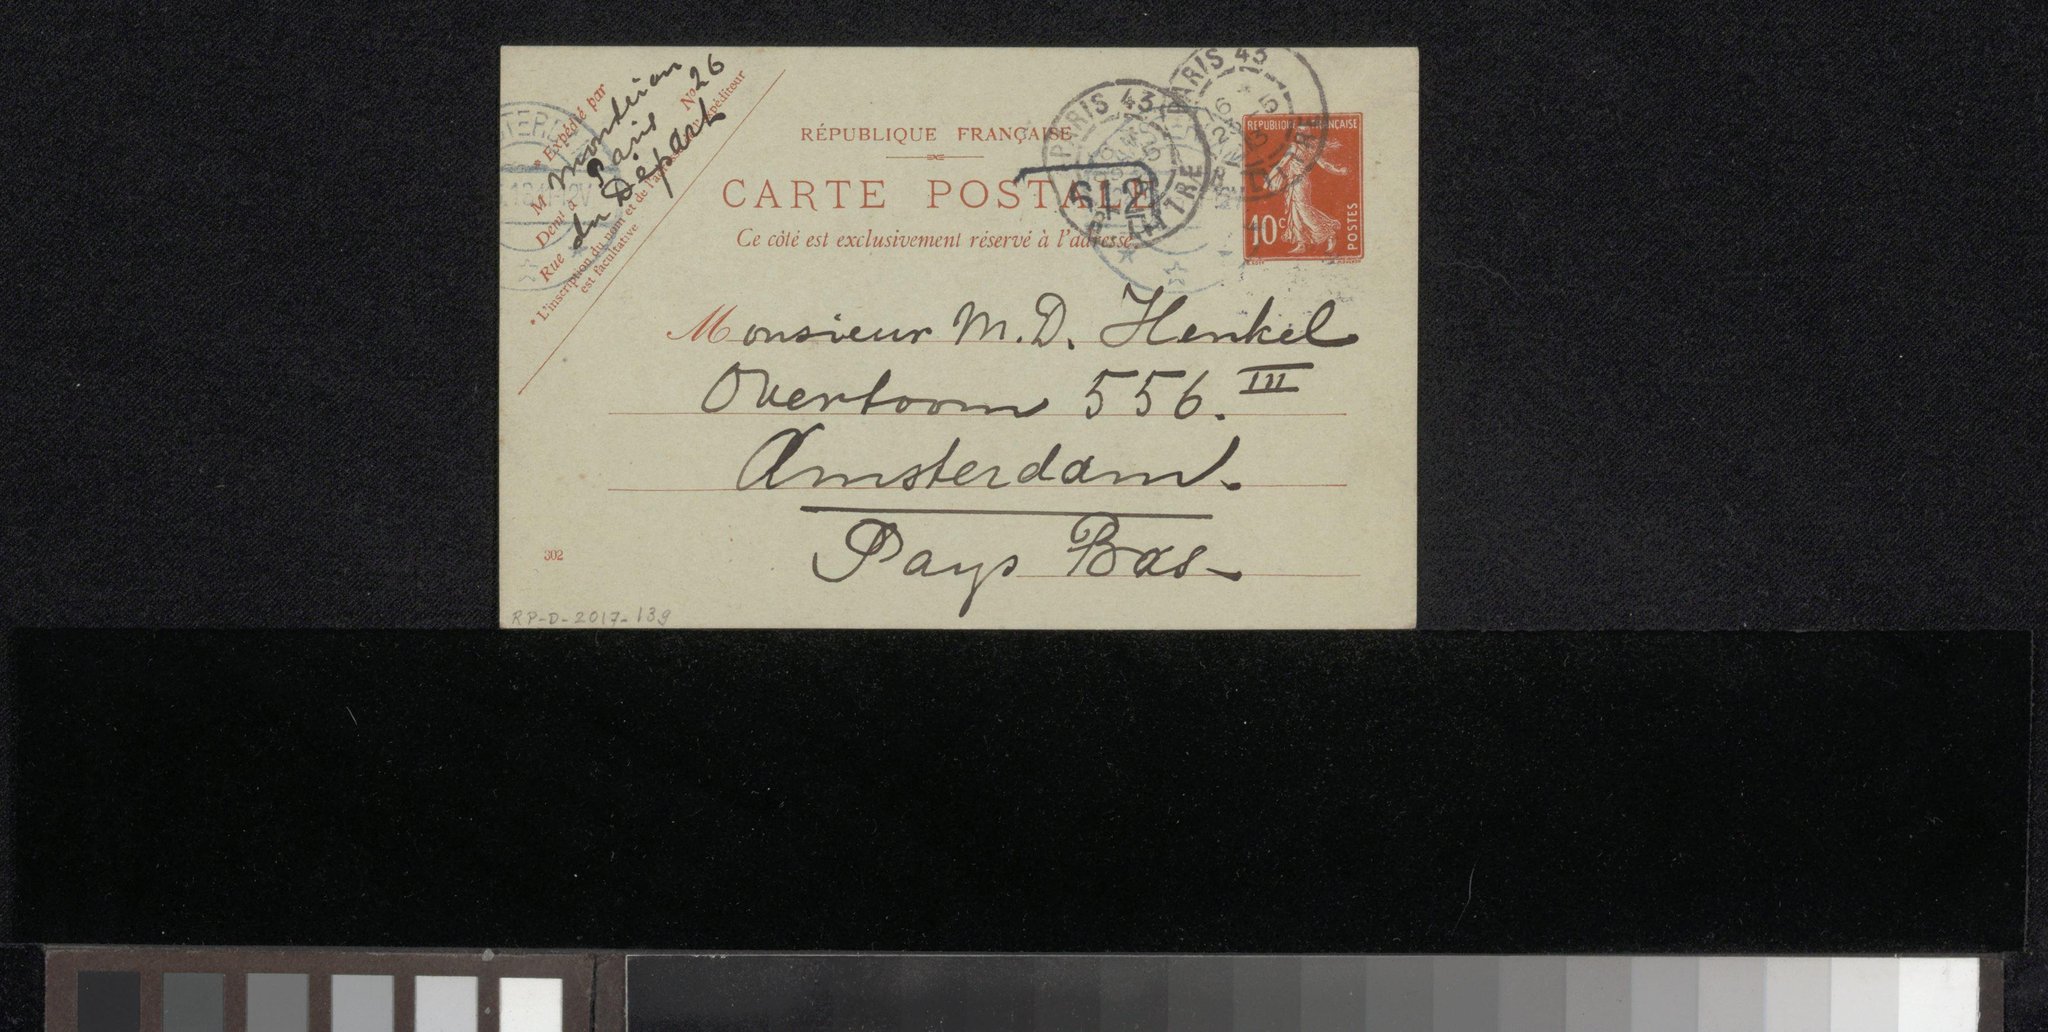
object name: postcard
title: Briefkaart aan Max Dittmar Henkel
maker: piet mondriaan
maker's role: print maker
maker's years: 1872-1944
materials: cardboard, ink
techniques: pen, writing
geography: paris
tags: max dittmar henkel, painting (including book-illumination, miniature-painting), money